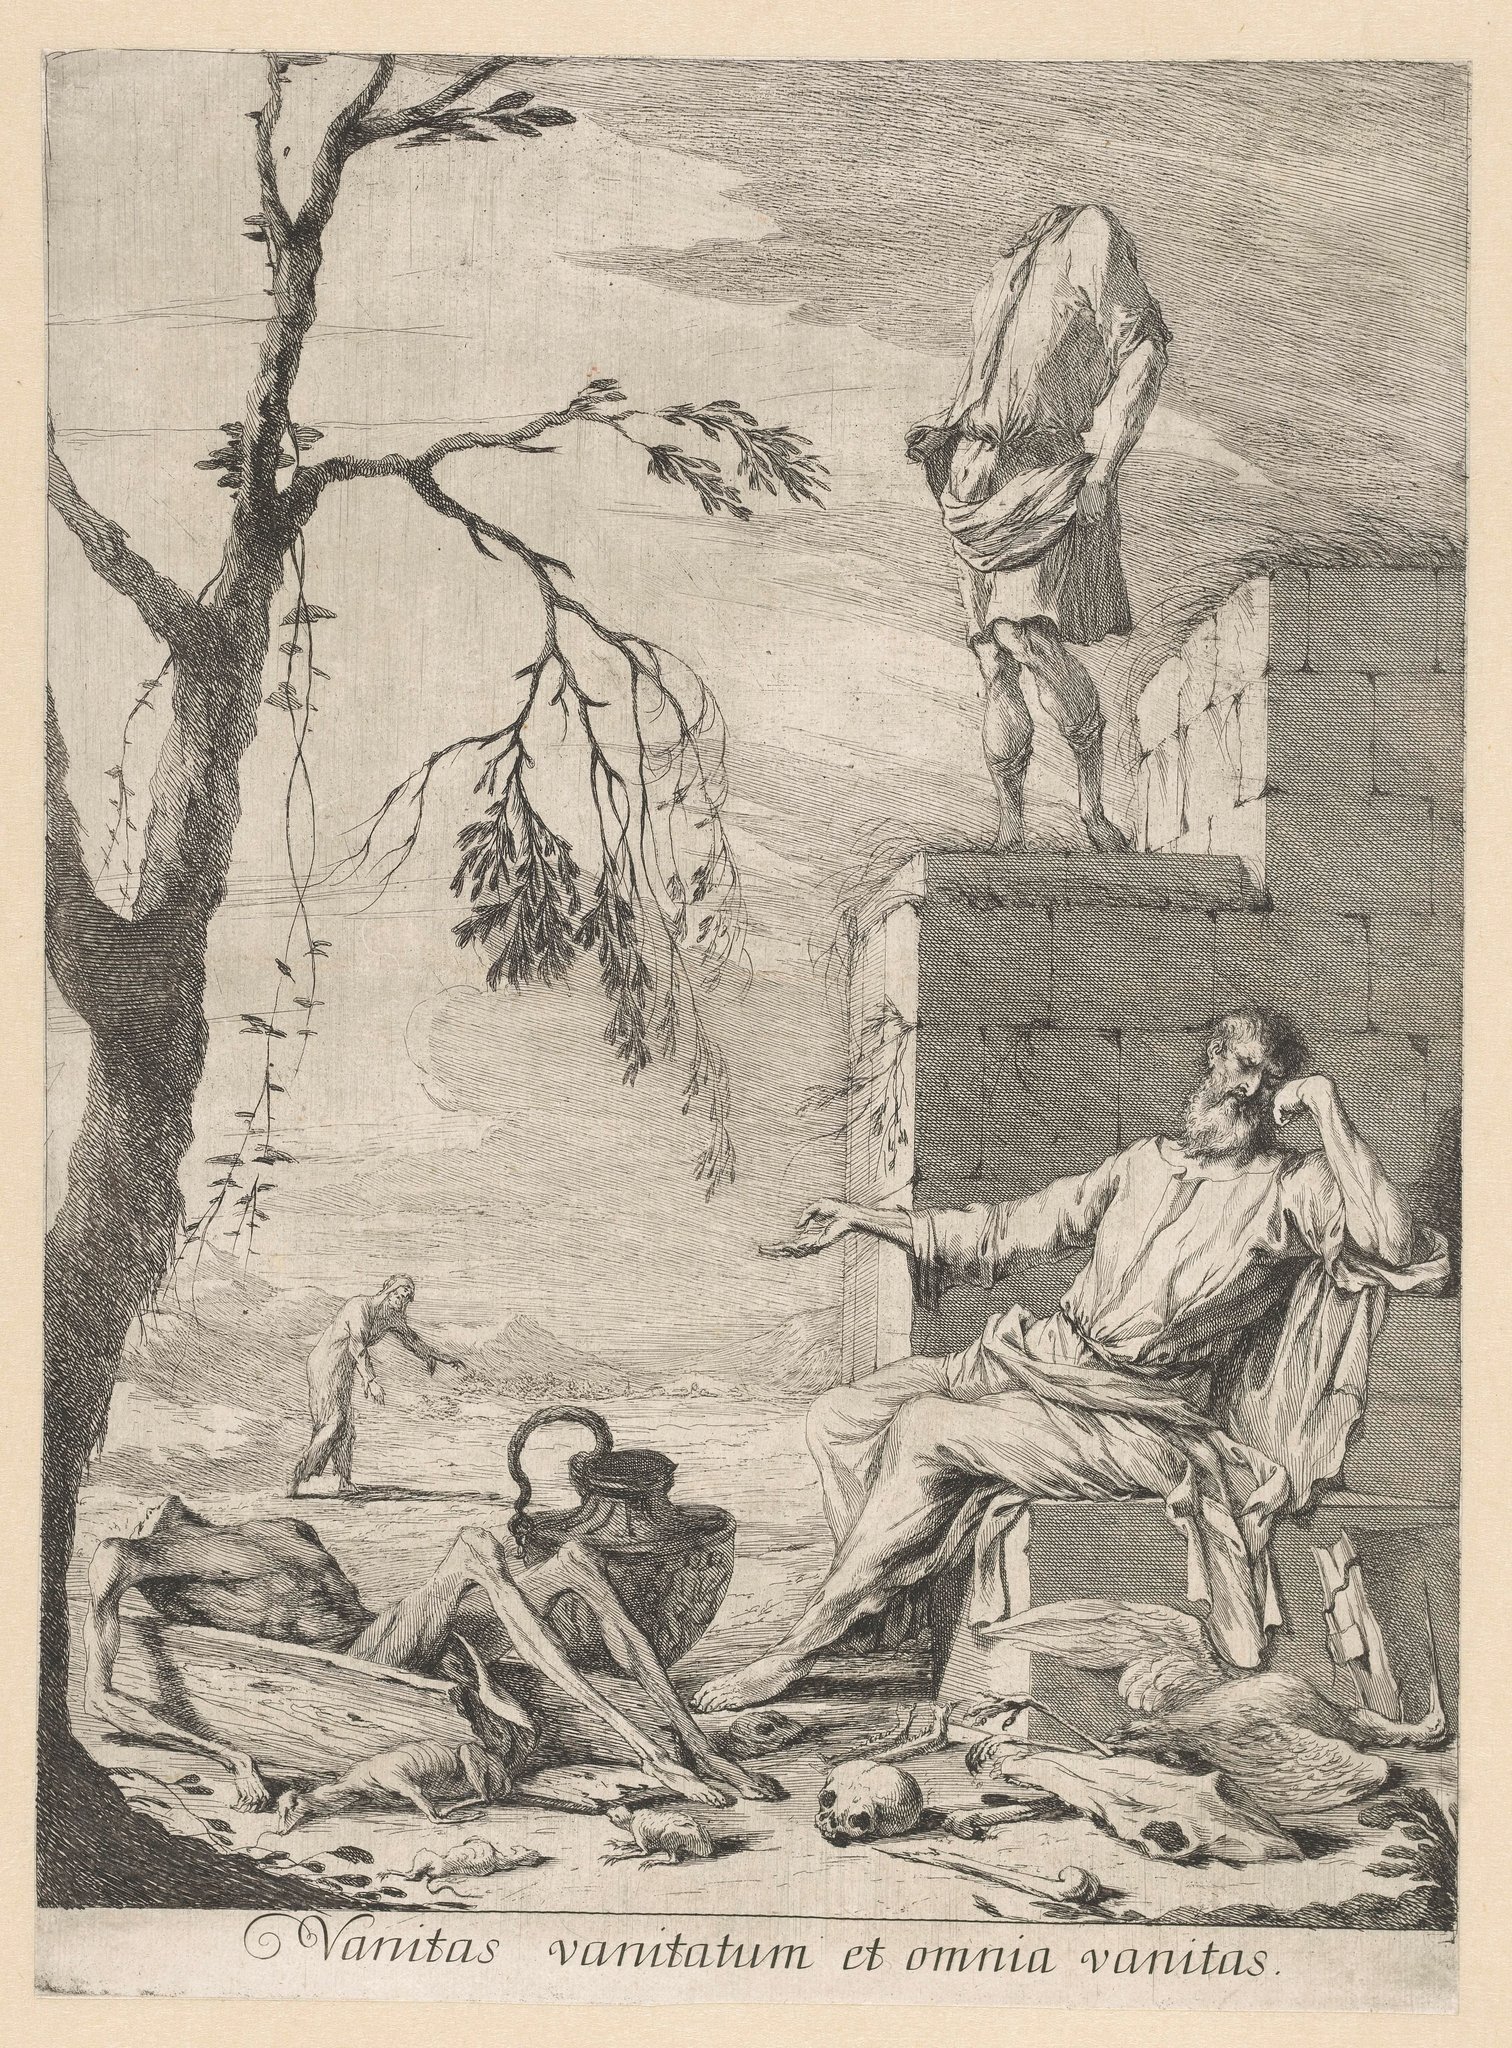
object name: print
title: Treurende filosoof omgeven door vanitas symboliek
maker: gabriel ehinger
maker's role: print maker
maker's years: 1652-1736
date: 1662-1736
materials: paper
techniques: etching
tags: tailless amphibians: frog, wandering scholar, scholar, philosopher, vase ~ ornament, 'vanitas' symbols, book, skull as symbol of 'vanitas', monument, statue, beggar, death of human being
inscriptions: collector's mark: Lugt 2760, collector's mark: Lugt 2228